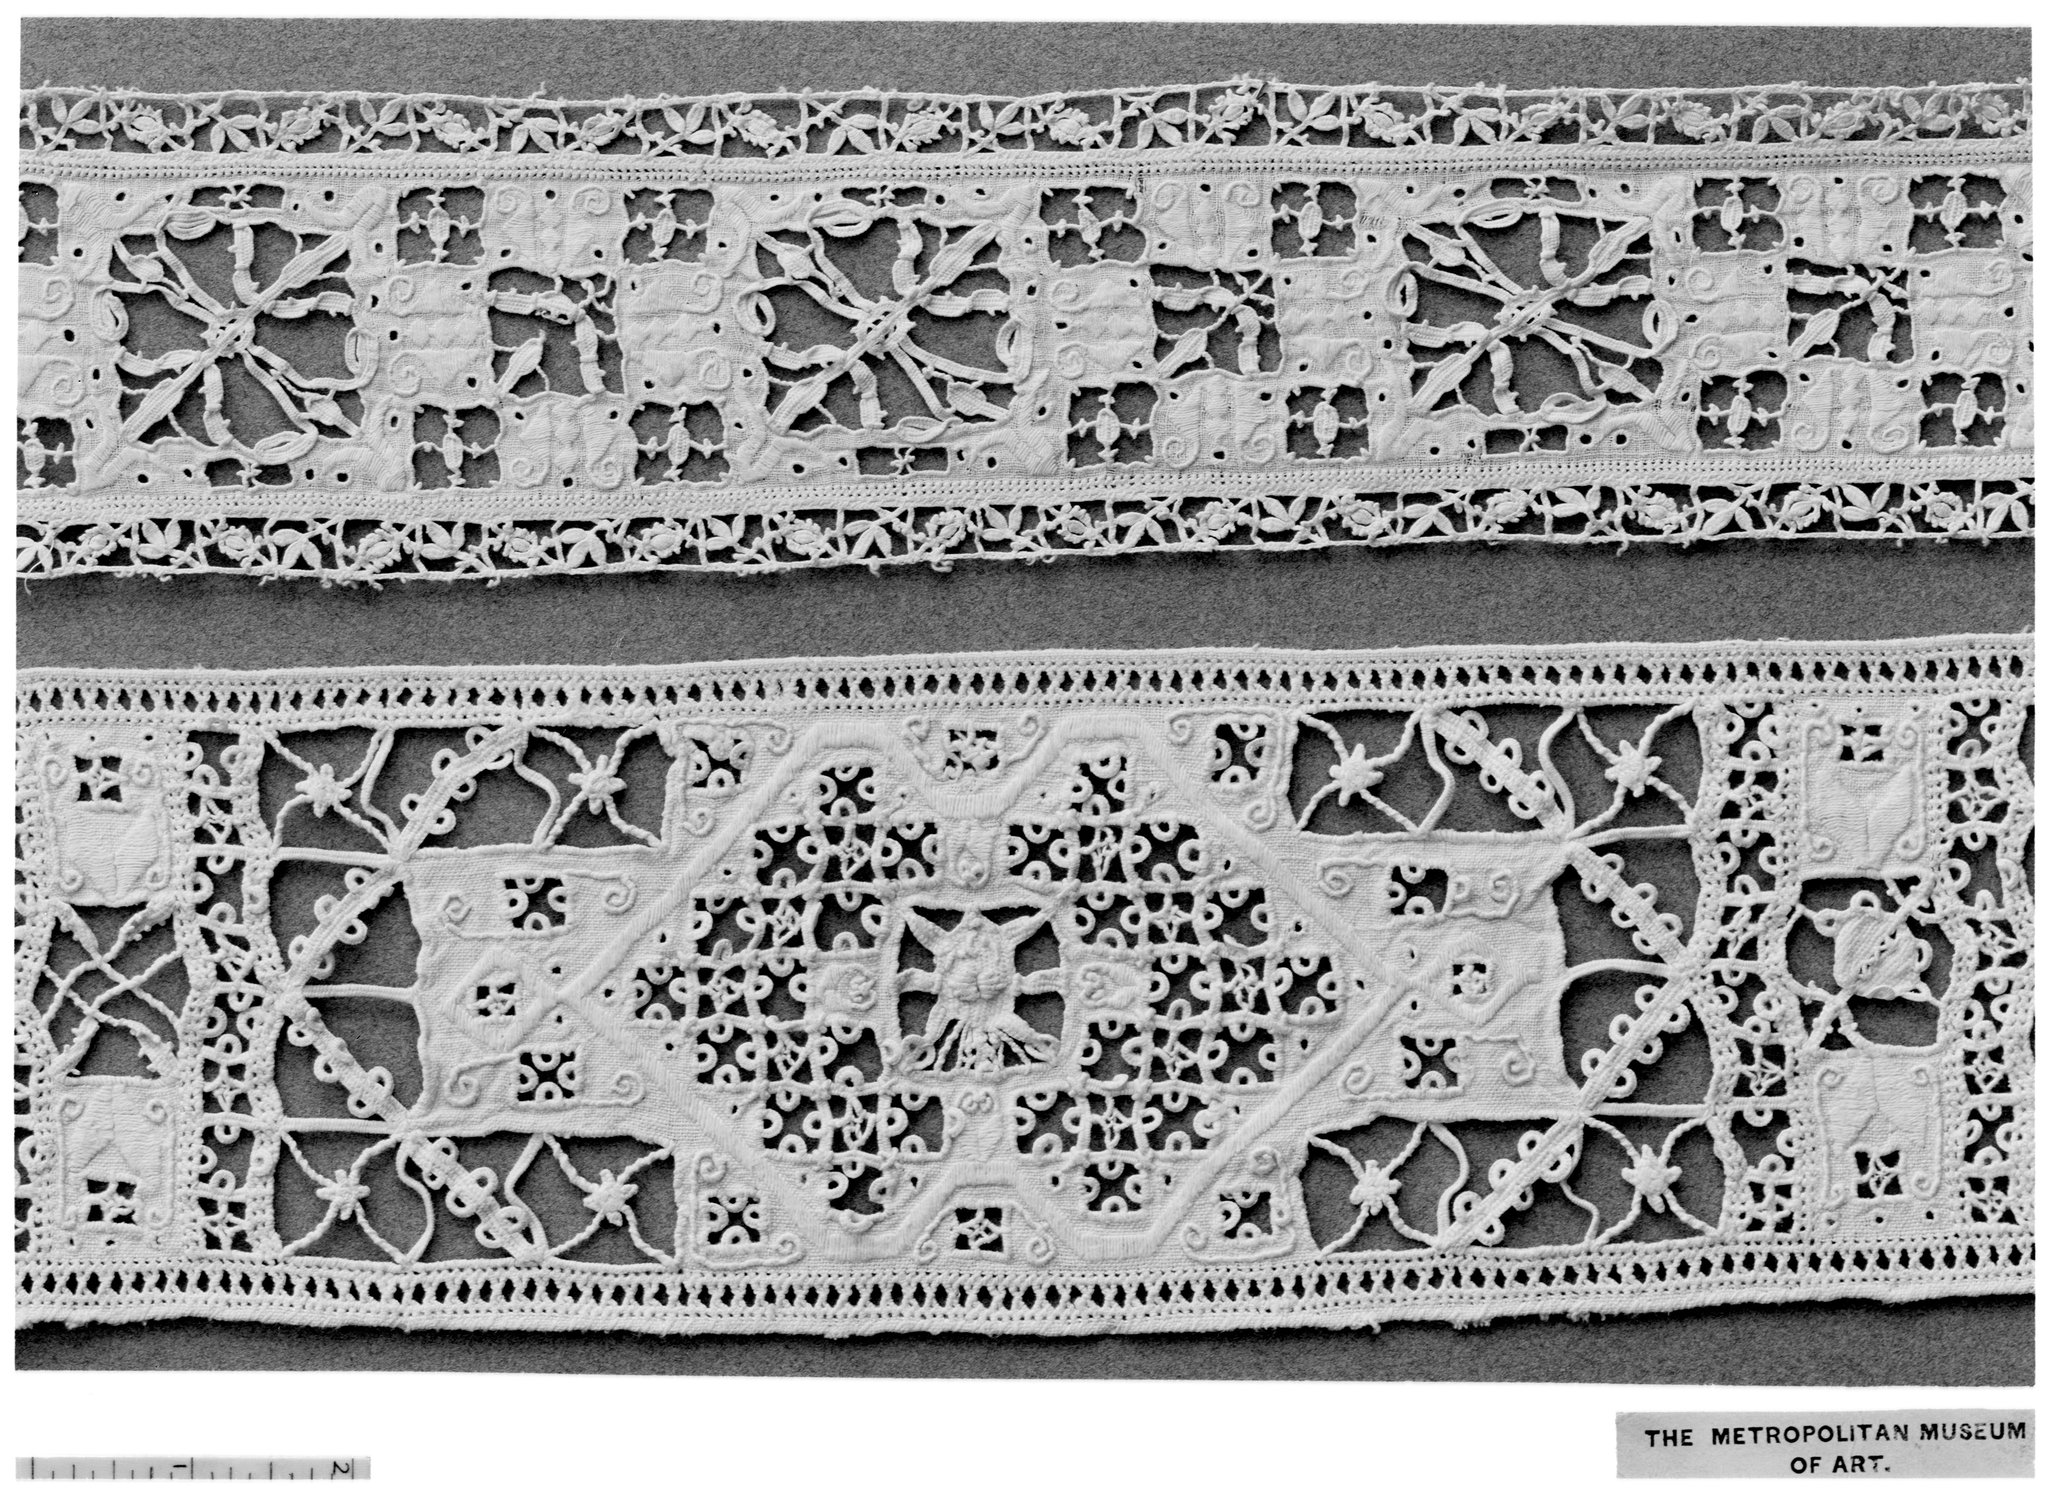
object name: strip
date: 1601-1700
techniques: embroidery